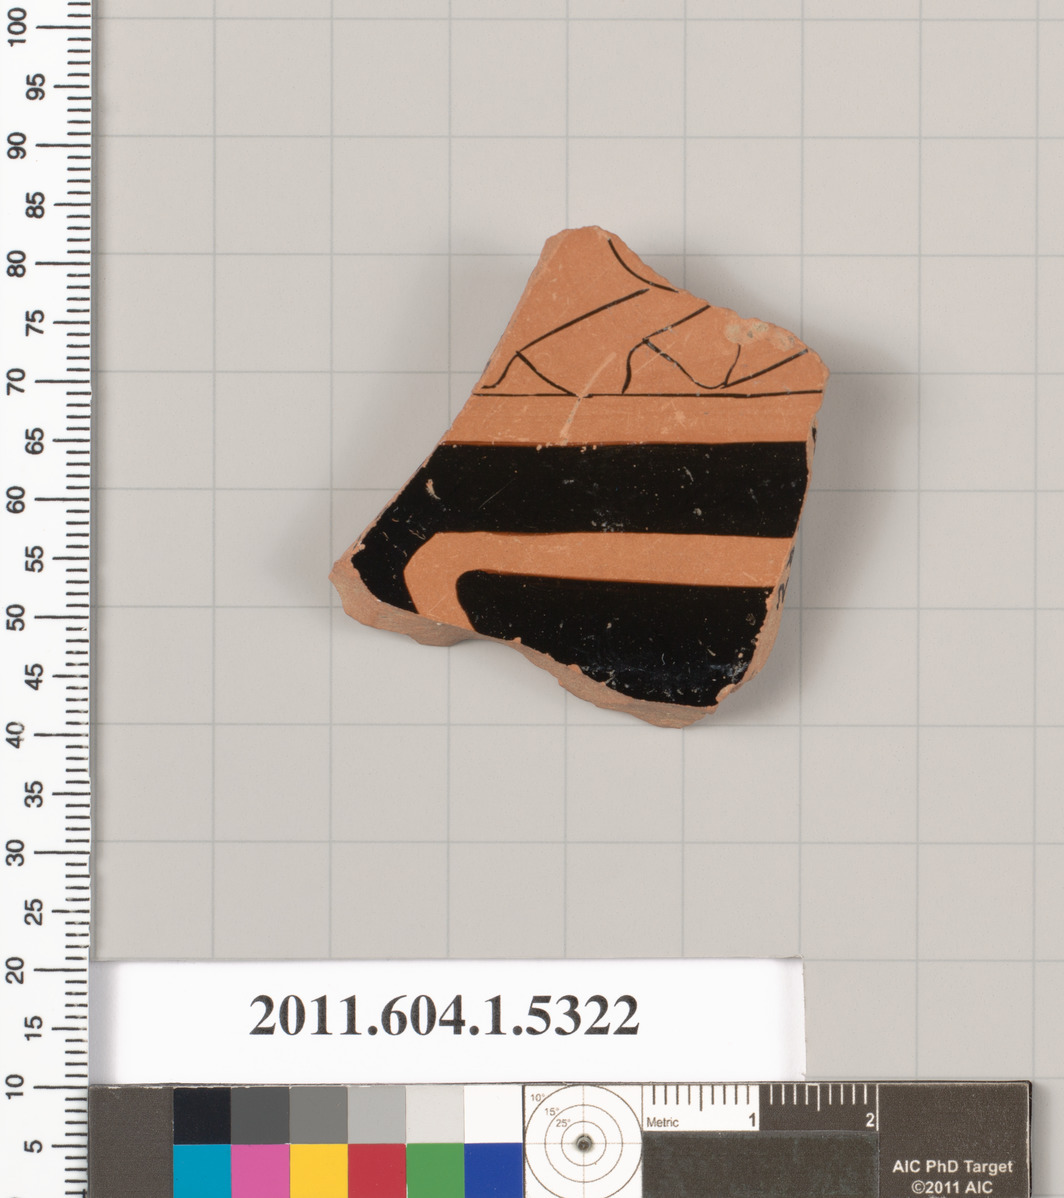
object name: kylix fragment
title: Terracotta fragment of a kylix (drinking cup)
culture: greek, attic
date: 500-480 BCE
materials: terracotta